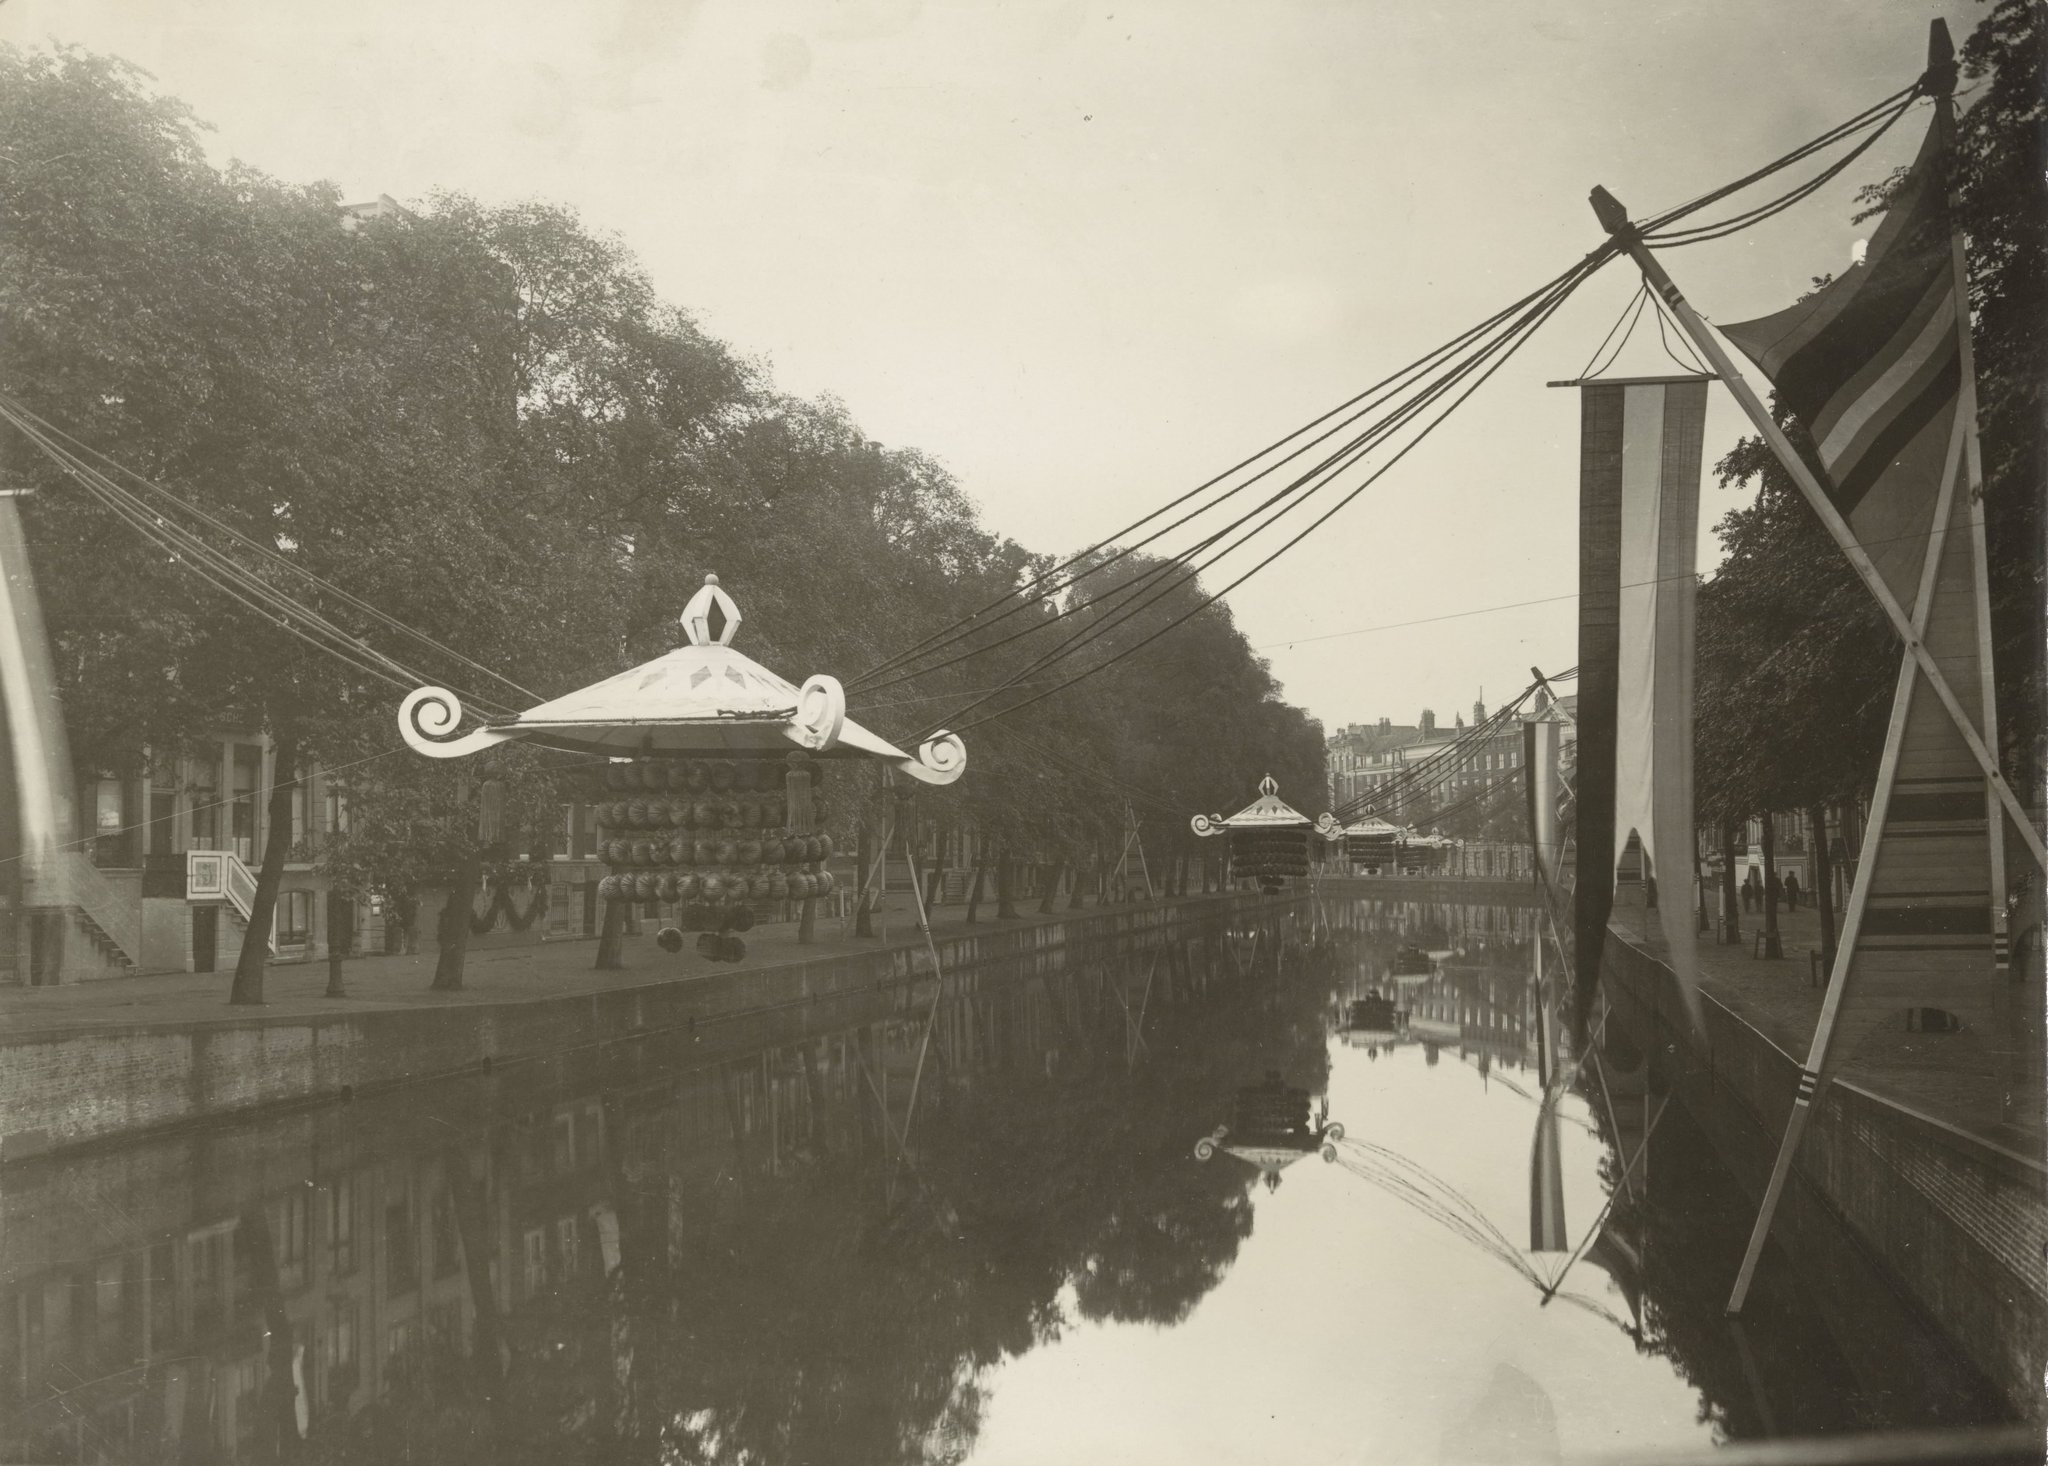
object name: photograph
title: Lampionnen en vaandels gespannen boven de Amsterdamse grachten ter gelegenheid van koninklijk bezoek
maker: Anonymous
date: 1898-1920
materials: photographic support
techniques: gelatin silver print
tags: wilhelmina of the netherlands, amsterdam